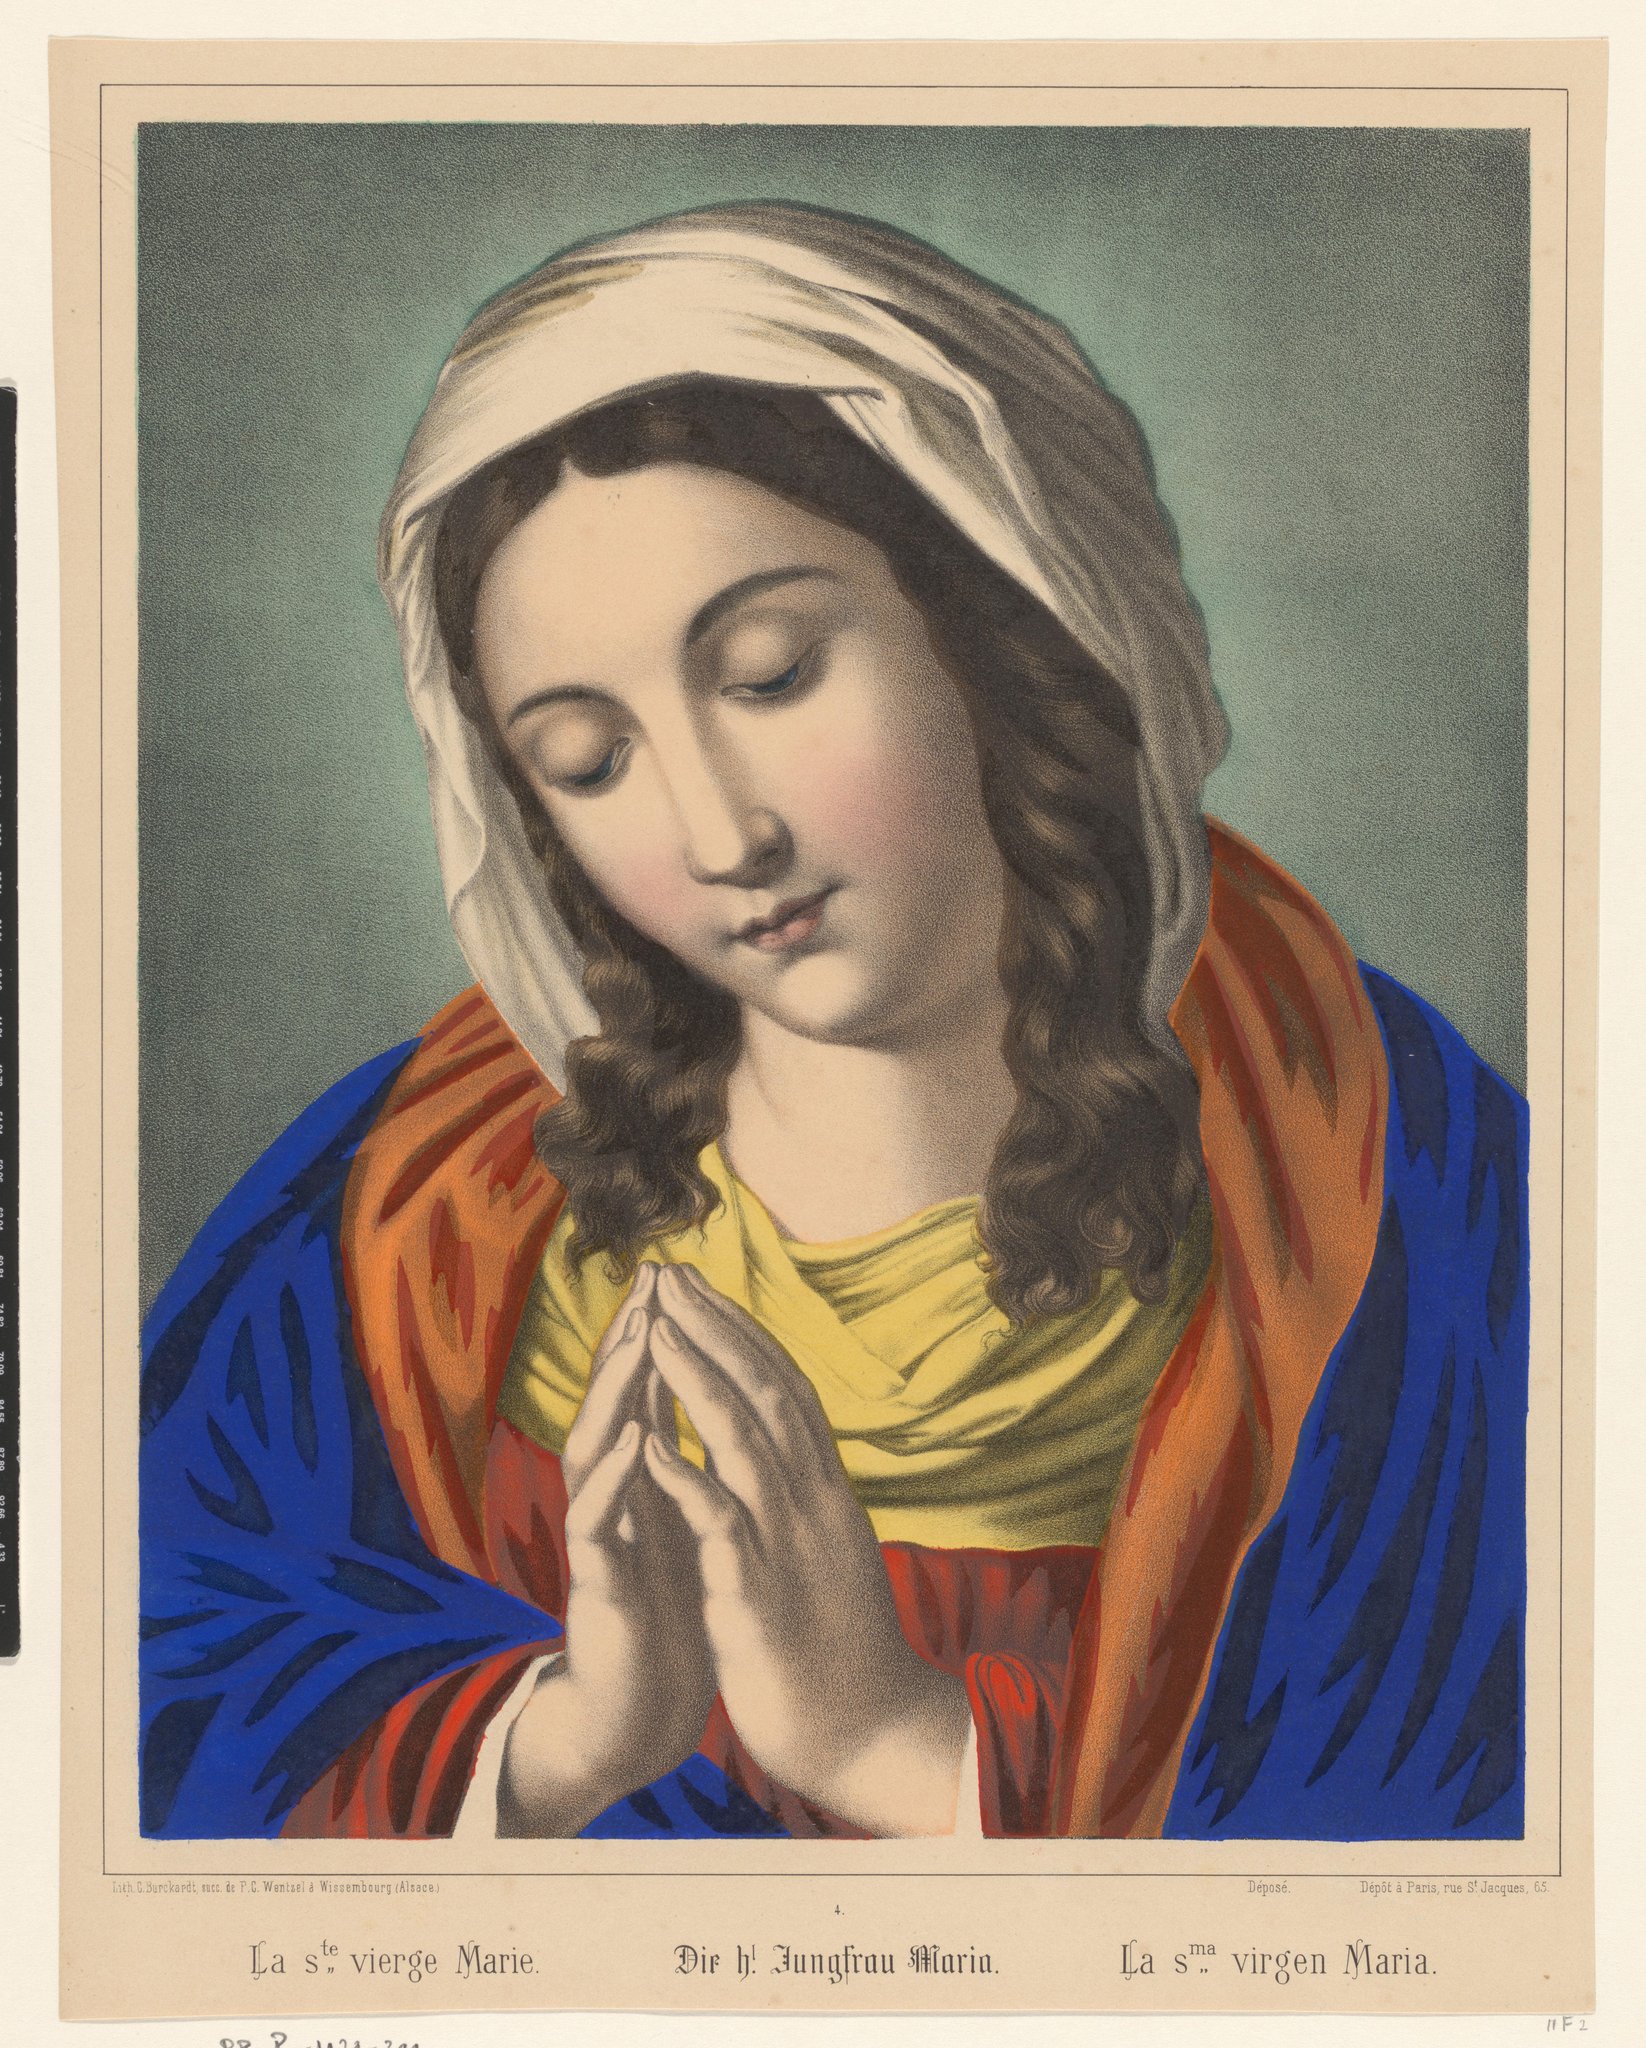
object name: print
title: De maagd Maria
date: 1850-1900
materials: paper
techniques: hand coloring, lithograph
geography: weissenburg